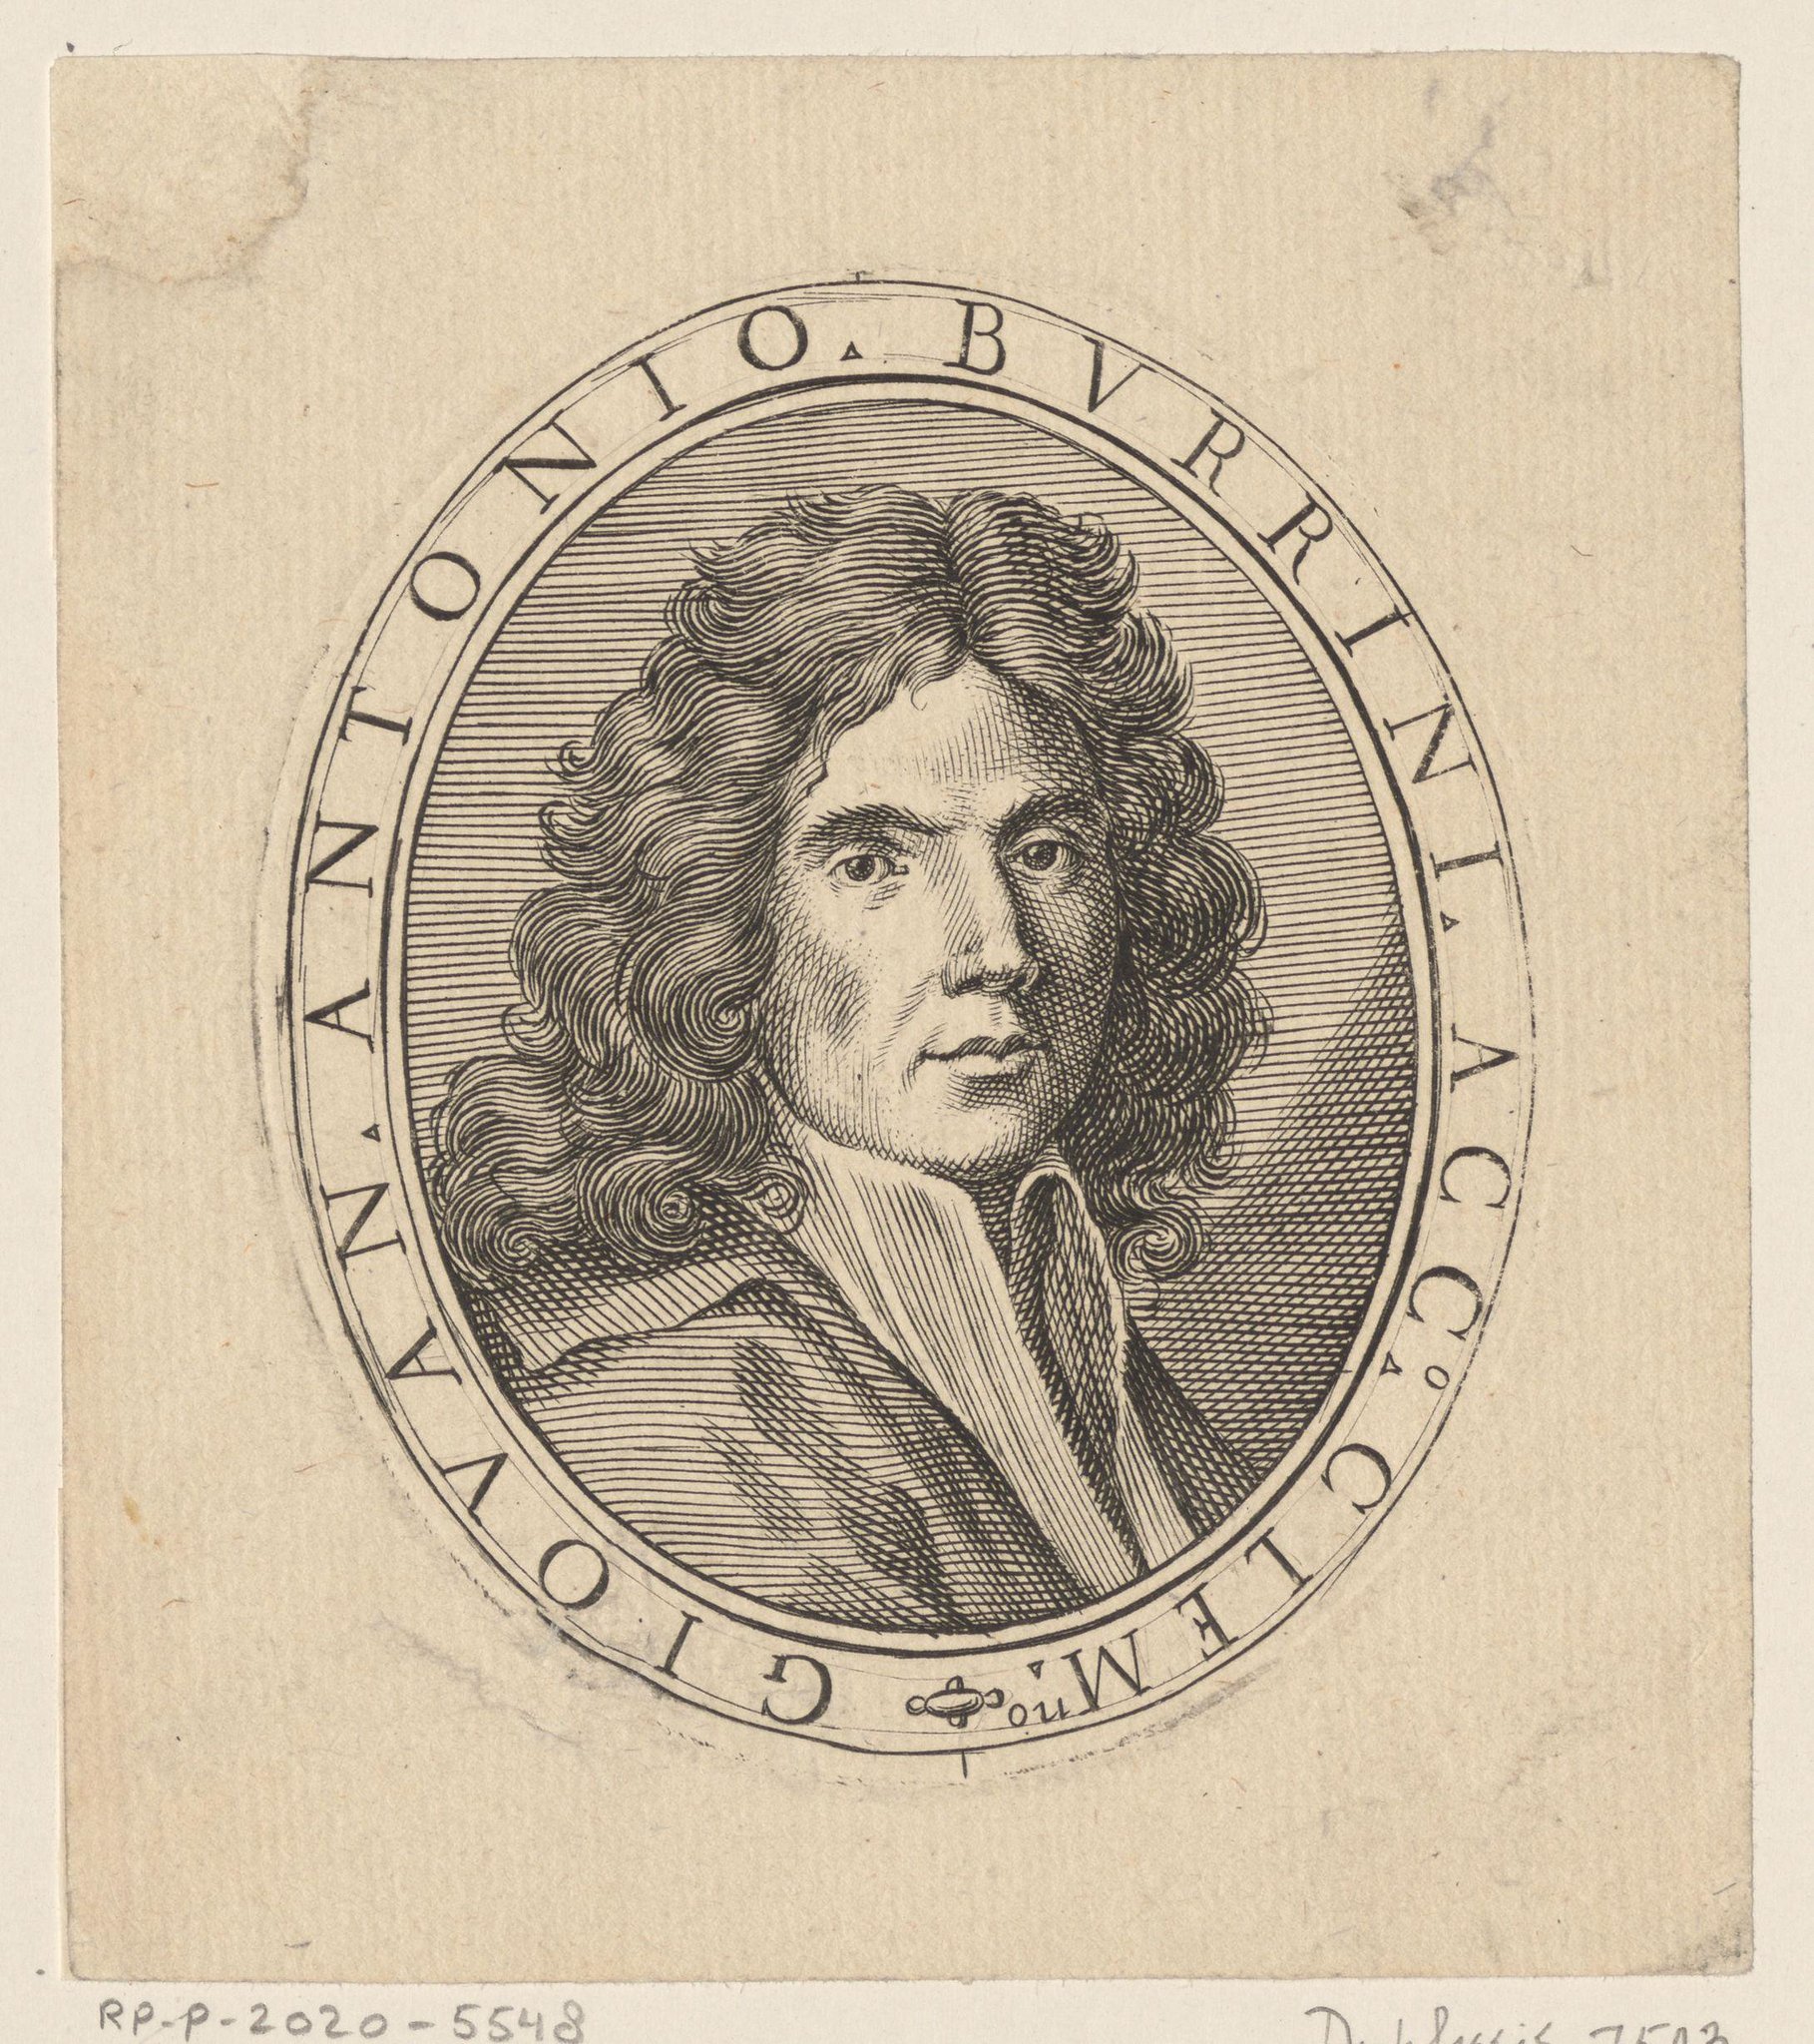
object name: print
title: Portret van Giovanni Antonio Burrini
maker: Anonymous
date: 1709-1749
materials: paper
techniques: engraving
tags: draughtsman, gian antonio burrini, commander-in-chief, general, marshal, historical persons